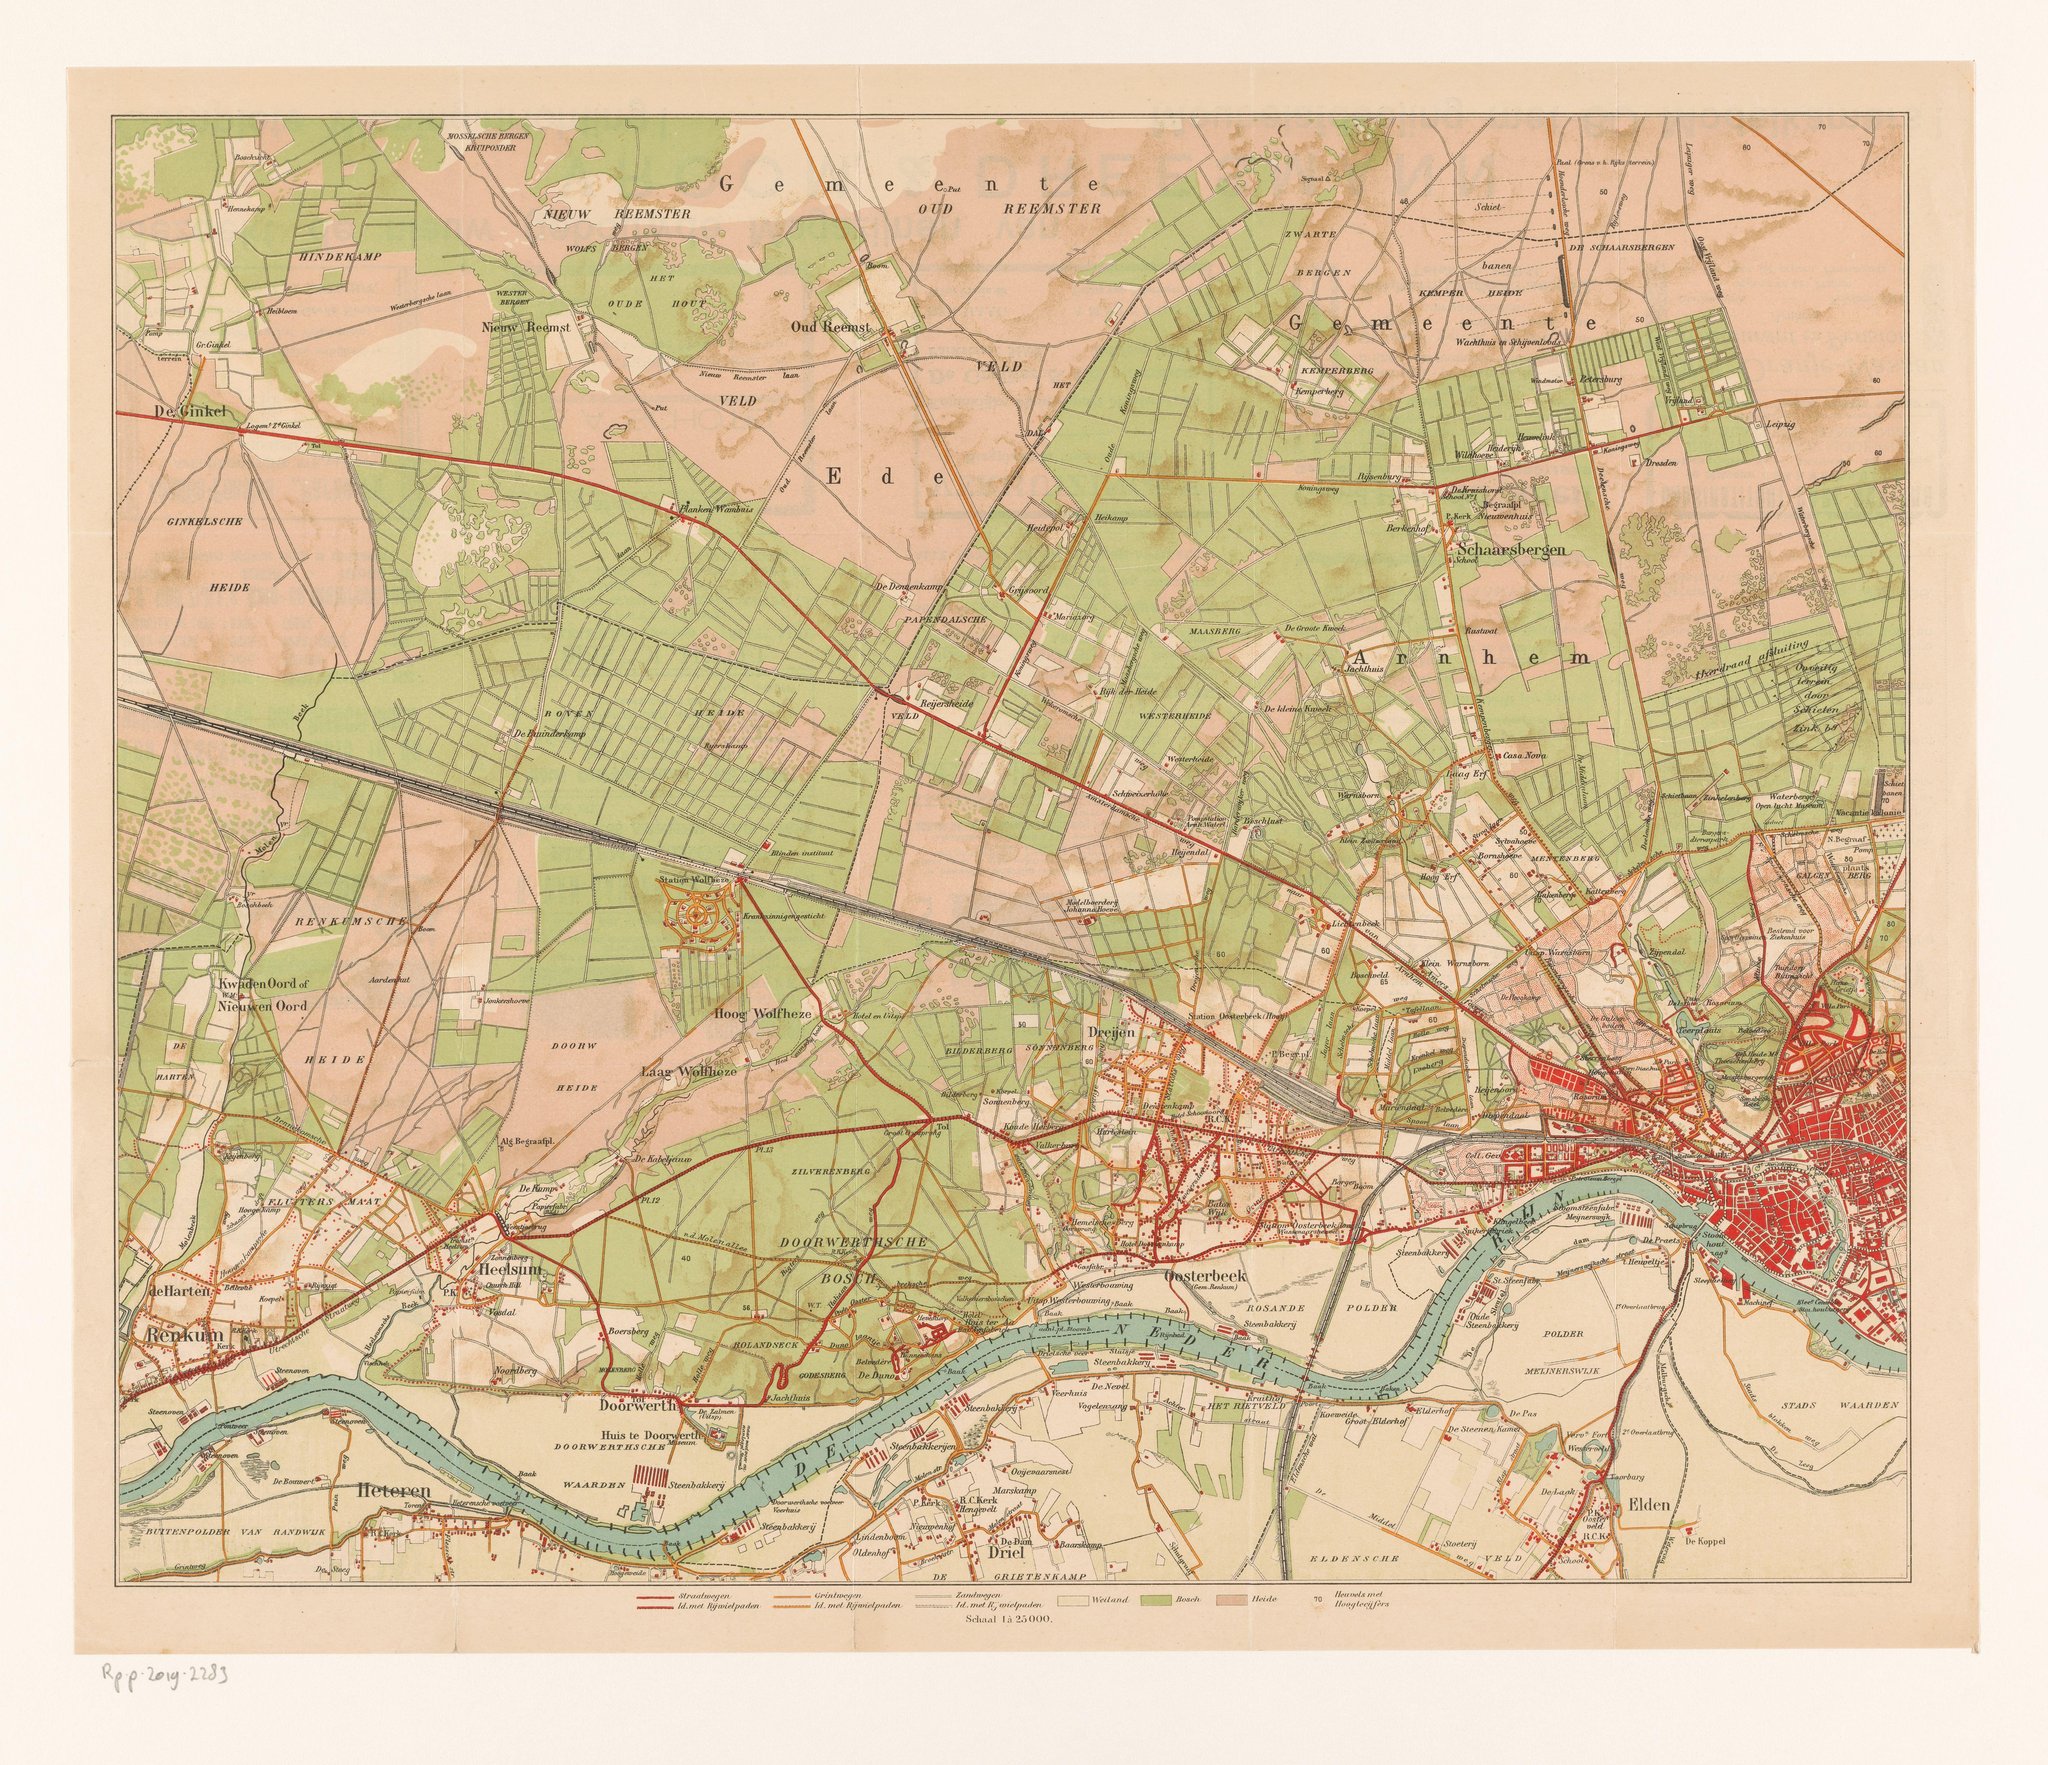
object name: print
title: Kaart van de omgeving van Arnhem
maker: Anonymous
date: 1929-1939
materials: paper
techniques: lithograph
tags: maps of separate countries or regions, gelderland, arnhem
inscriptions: collector's mark: Lugt 2228